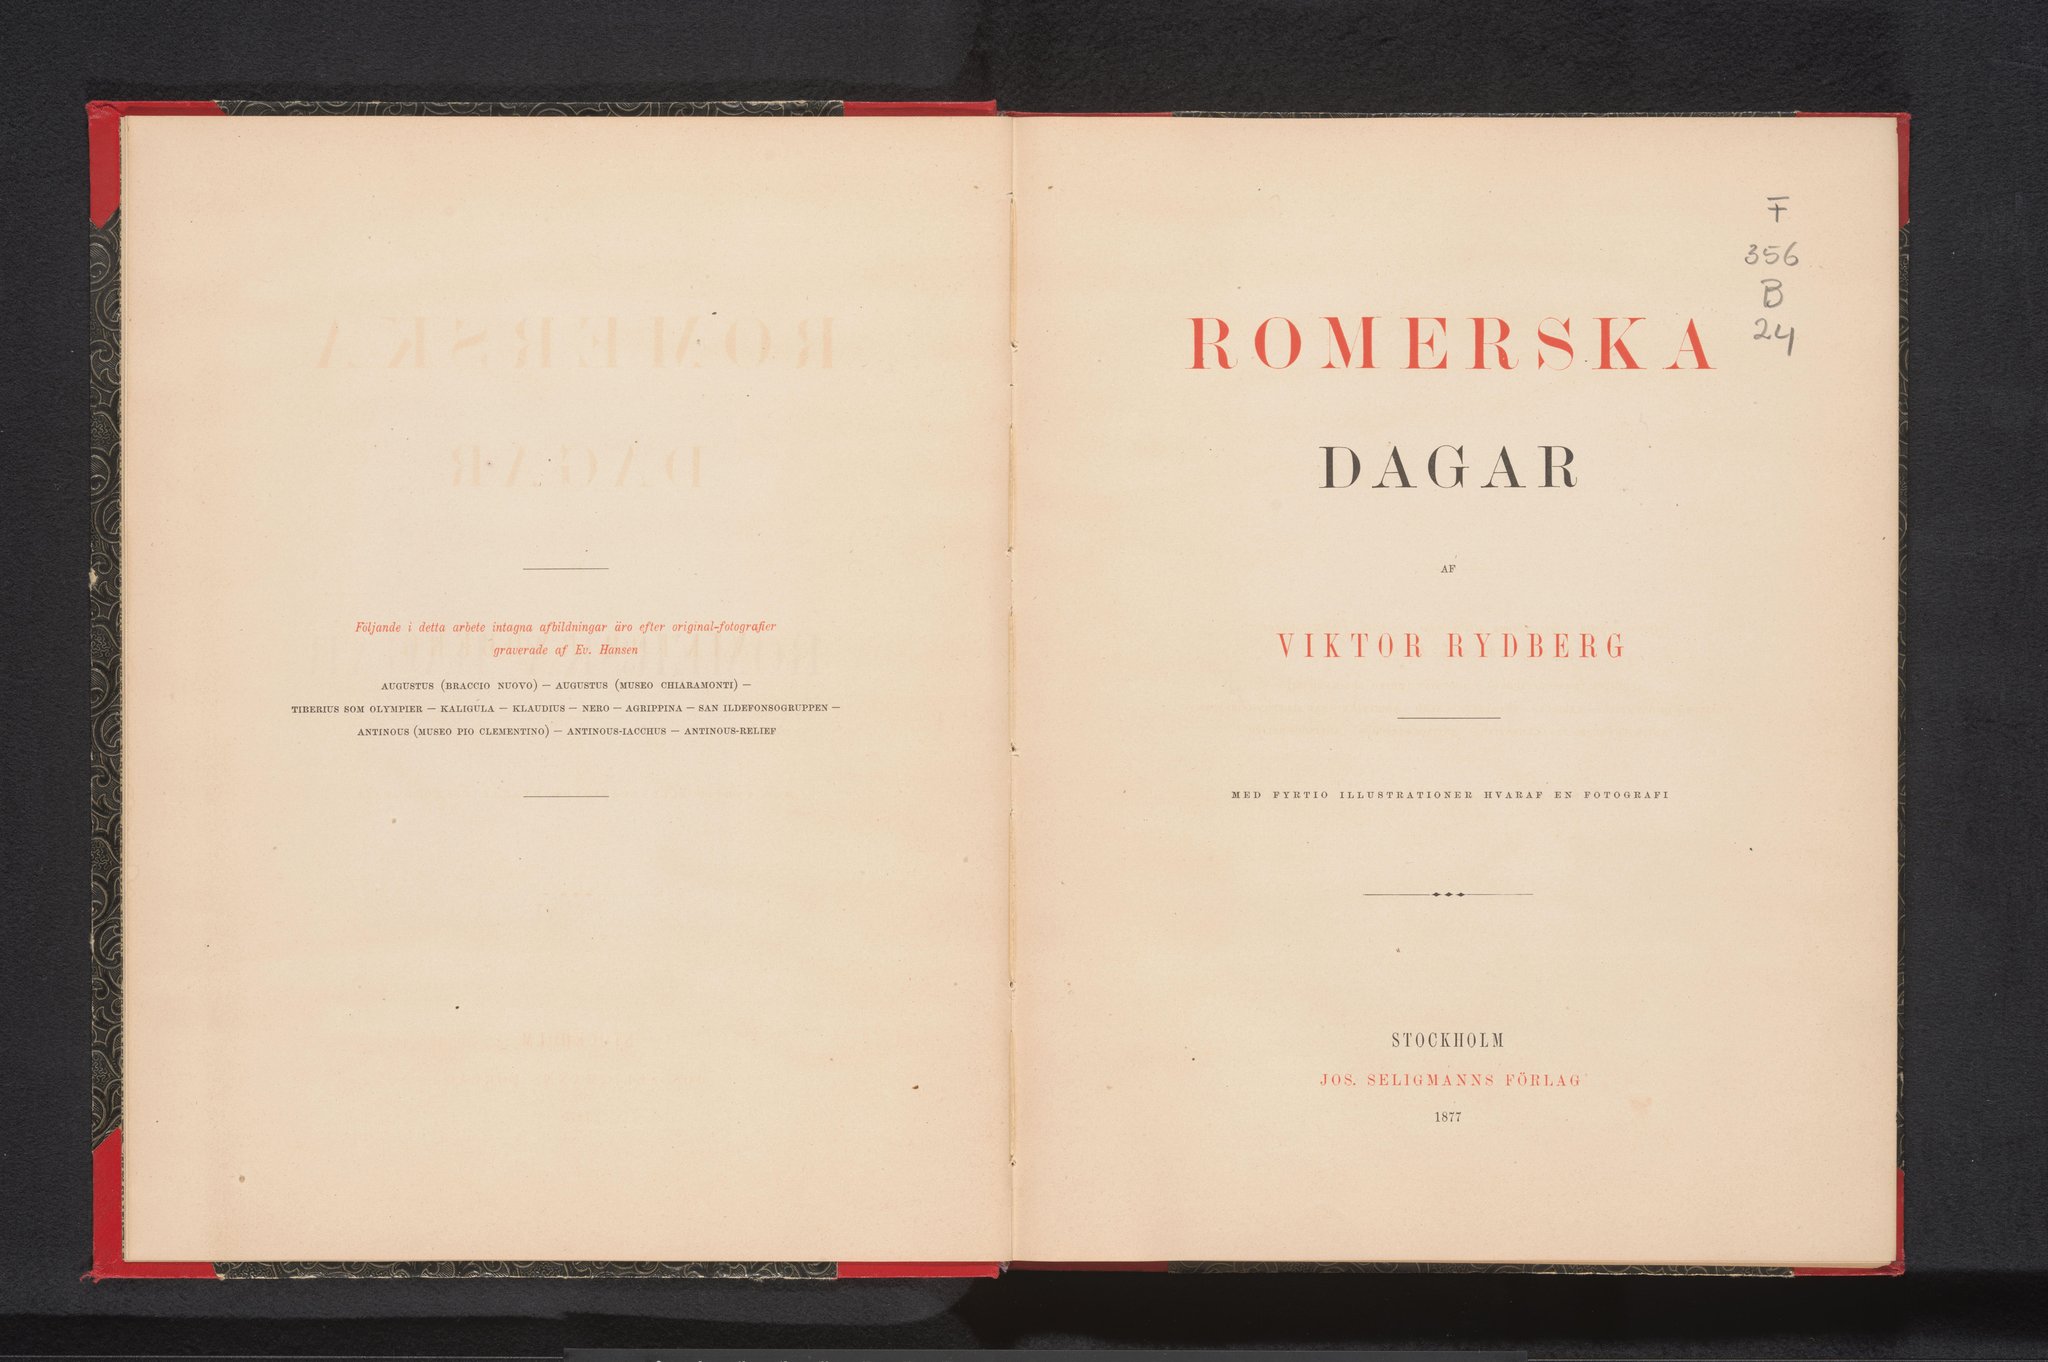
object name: book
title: Romerska dagar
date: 1877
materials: cardboard, linen, paper, photographic support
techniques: albumen print, engraving, printing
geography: stockholm